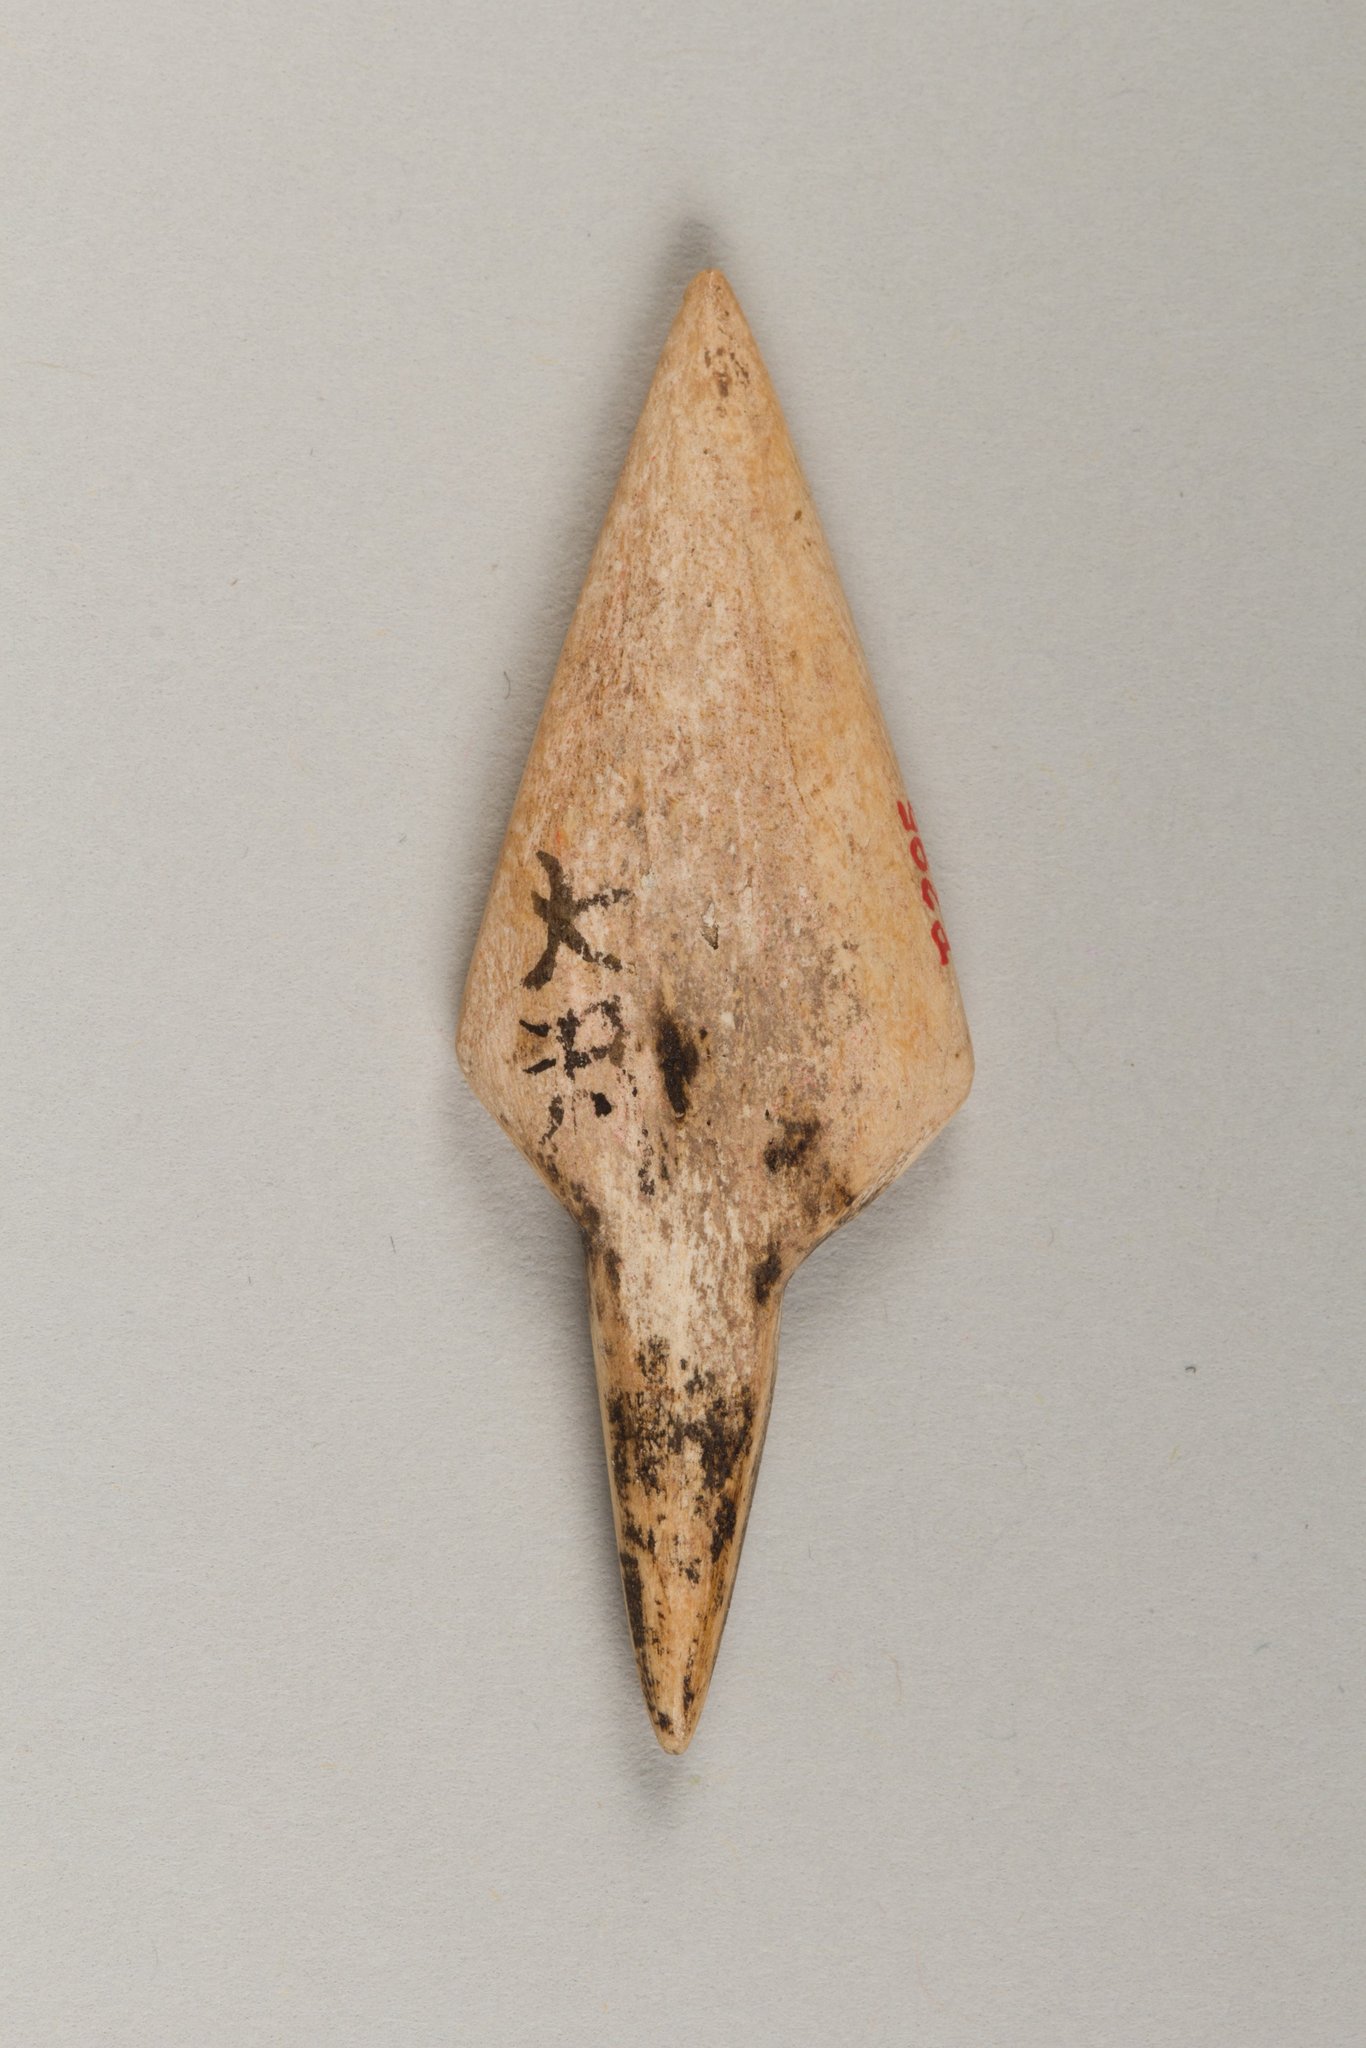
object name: arrowhead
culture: japanese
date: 1000-300 BCE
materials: bone